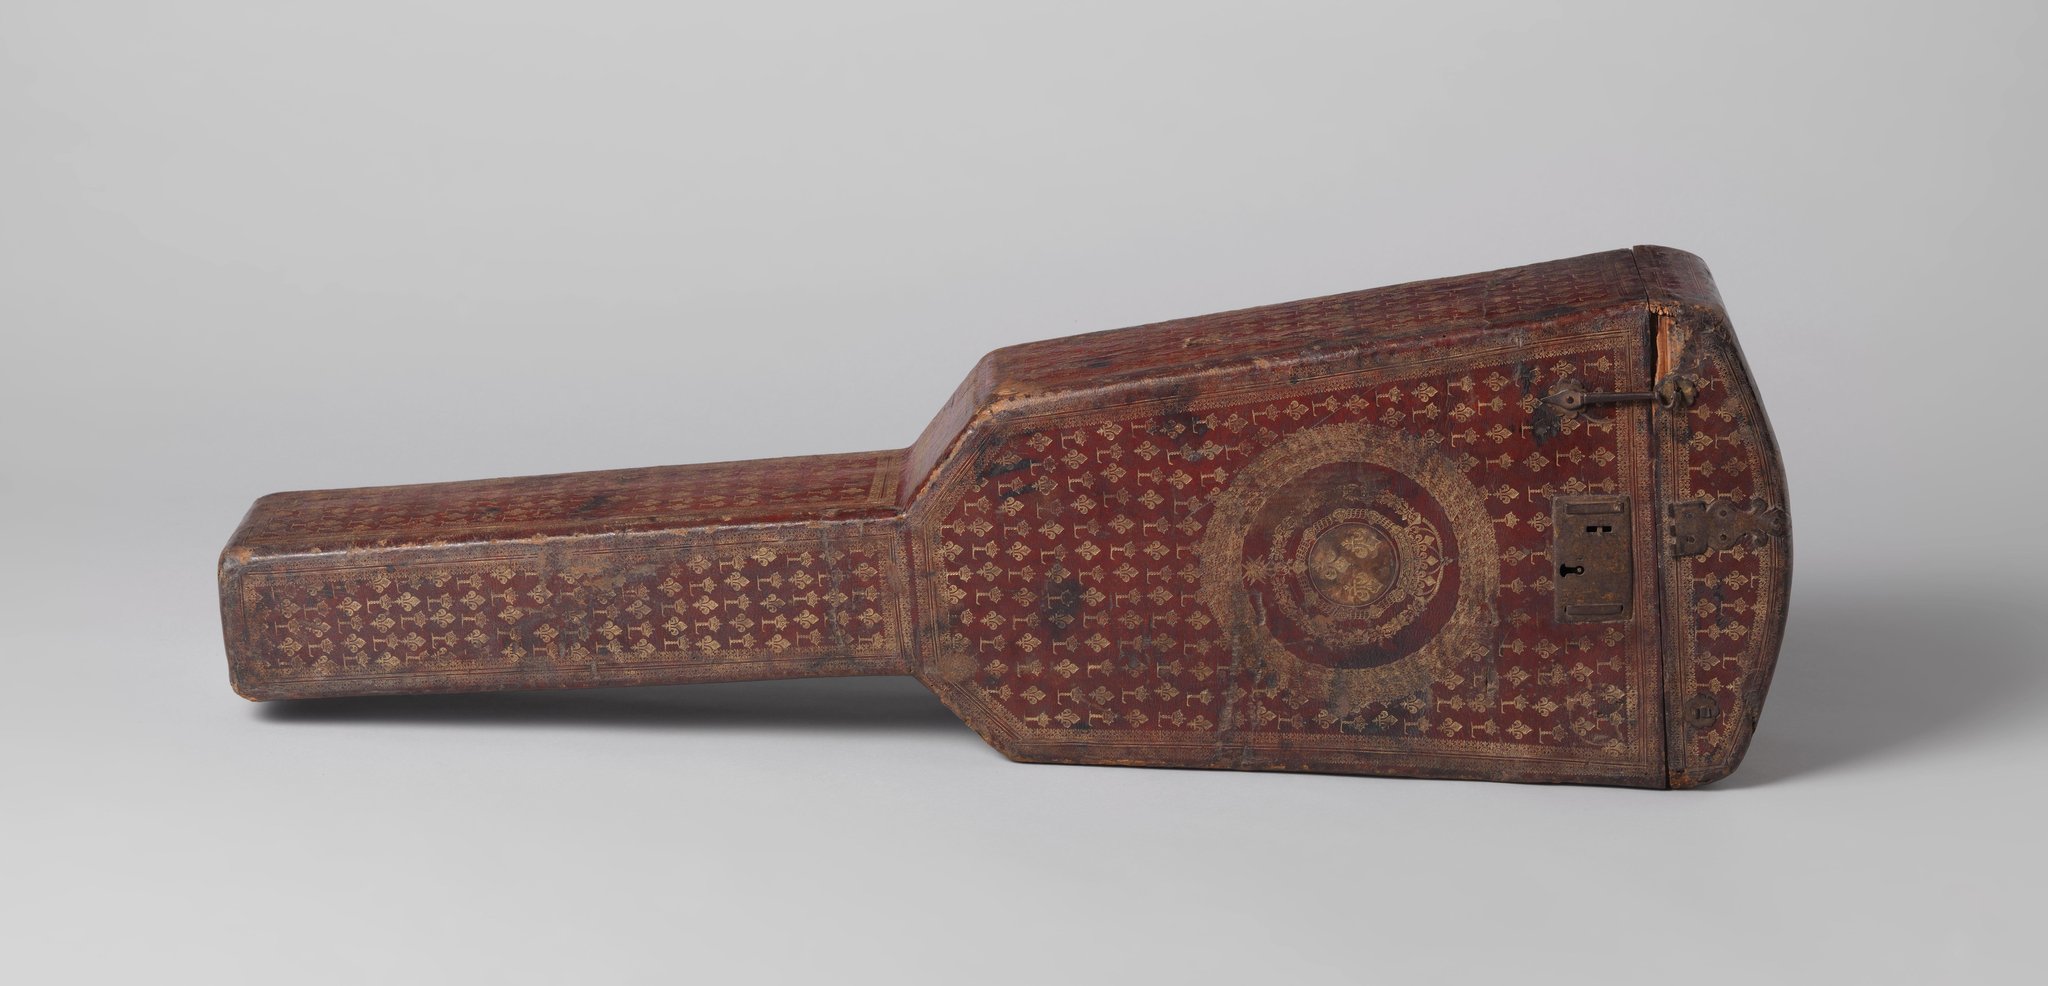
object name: element of musical instrument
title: Guitar case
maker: Anonymous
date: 1610-1643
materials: leather, wood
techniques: gilding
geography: france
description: Met rode leer overtrokken houten gitaarkist. Bovenop een gekroond wapen met drie lelies waaromheen de ordeband van St. Michael. Leer overal bestempeld met lelies afwisselend met kronen boven de letter L. Opening aan het eind met draad scharnieren. Klep blijft dicht door middel van decoratieve slot (gesp ontbreekt) en haak , beide van ijzer, waarschijnlijk ooit verguld. Voering van roze gewatteerde zijde.